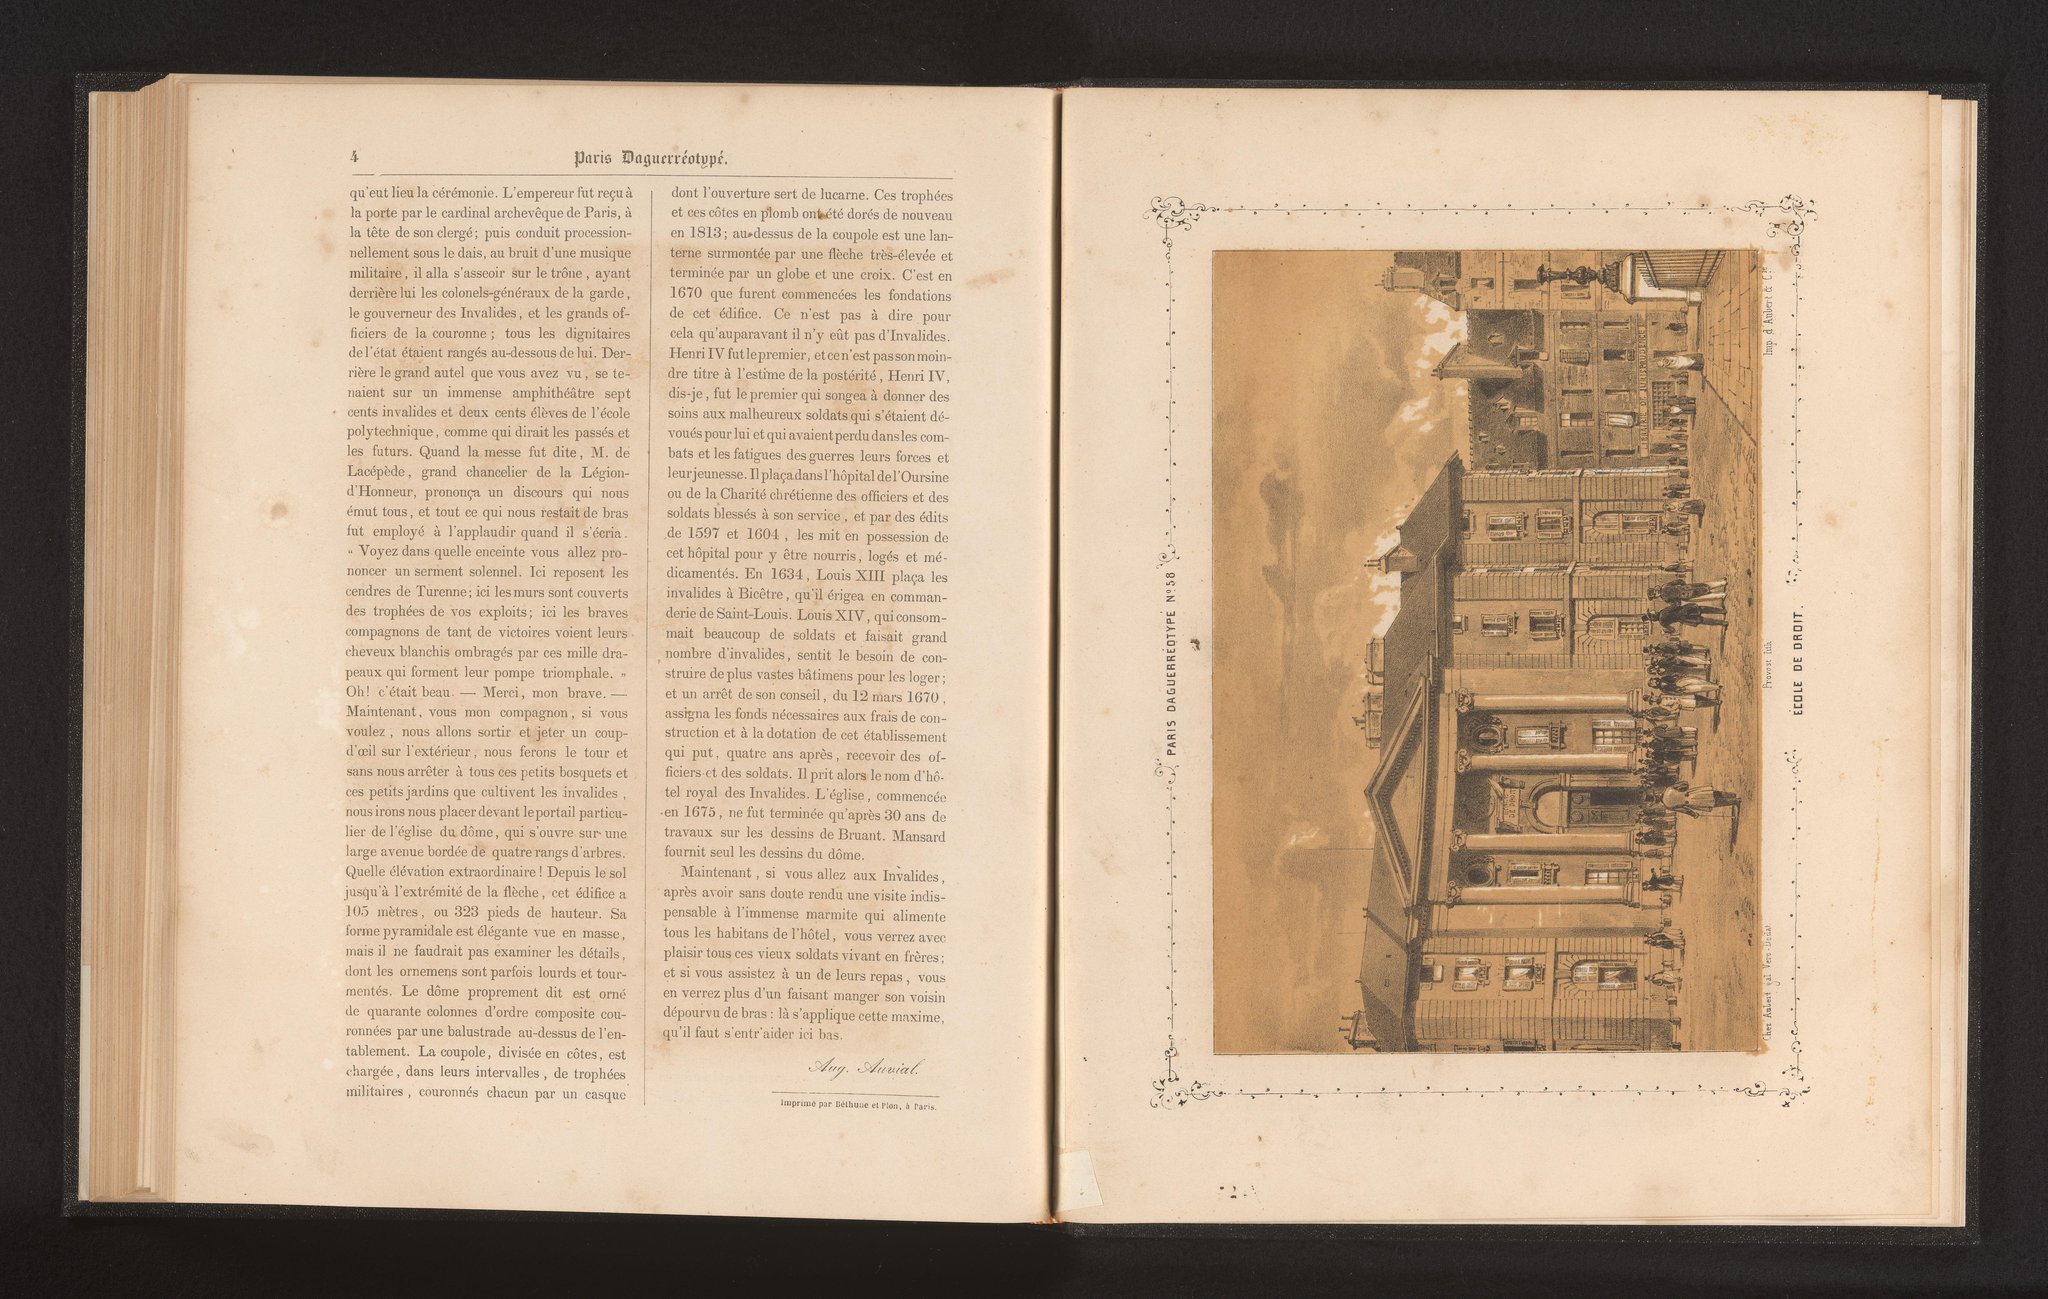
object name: page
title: Faculteit der Rechtsgeleerdheid van de Sorbonne in Parijs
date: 1839-1840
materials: paper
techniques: tone lithography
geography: paris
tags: faculties ~ university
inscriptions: inscription: ‘PARIS DAGUERRÉOTYPÉ No. 58.’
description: Prent op tweehonderdeenendertigste ongenummerde pagina.